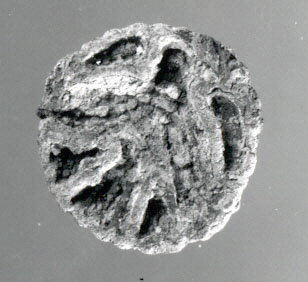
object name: stamp seal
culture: bactria-margiana archaeological complex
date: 2333-1668 BCE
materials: copper alloy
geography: bactria-margiana